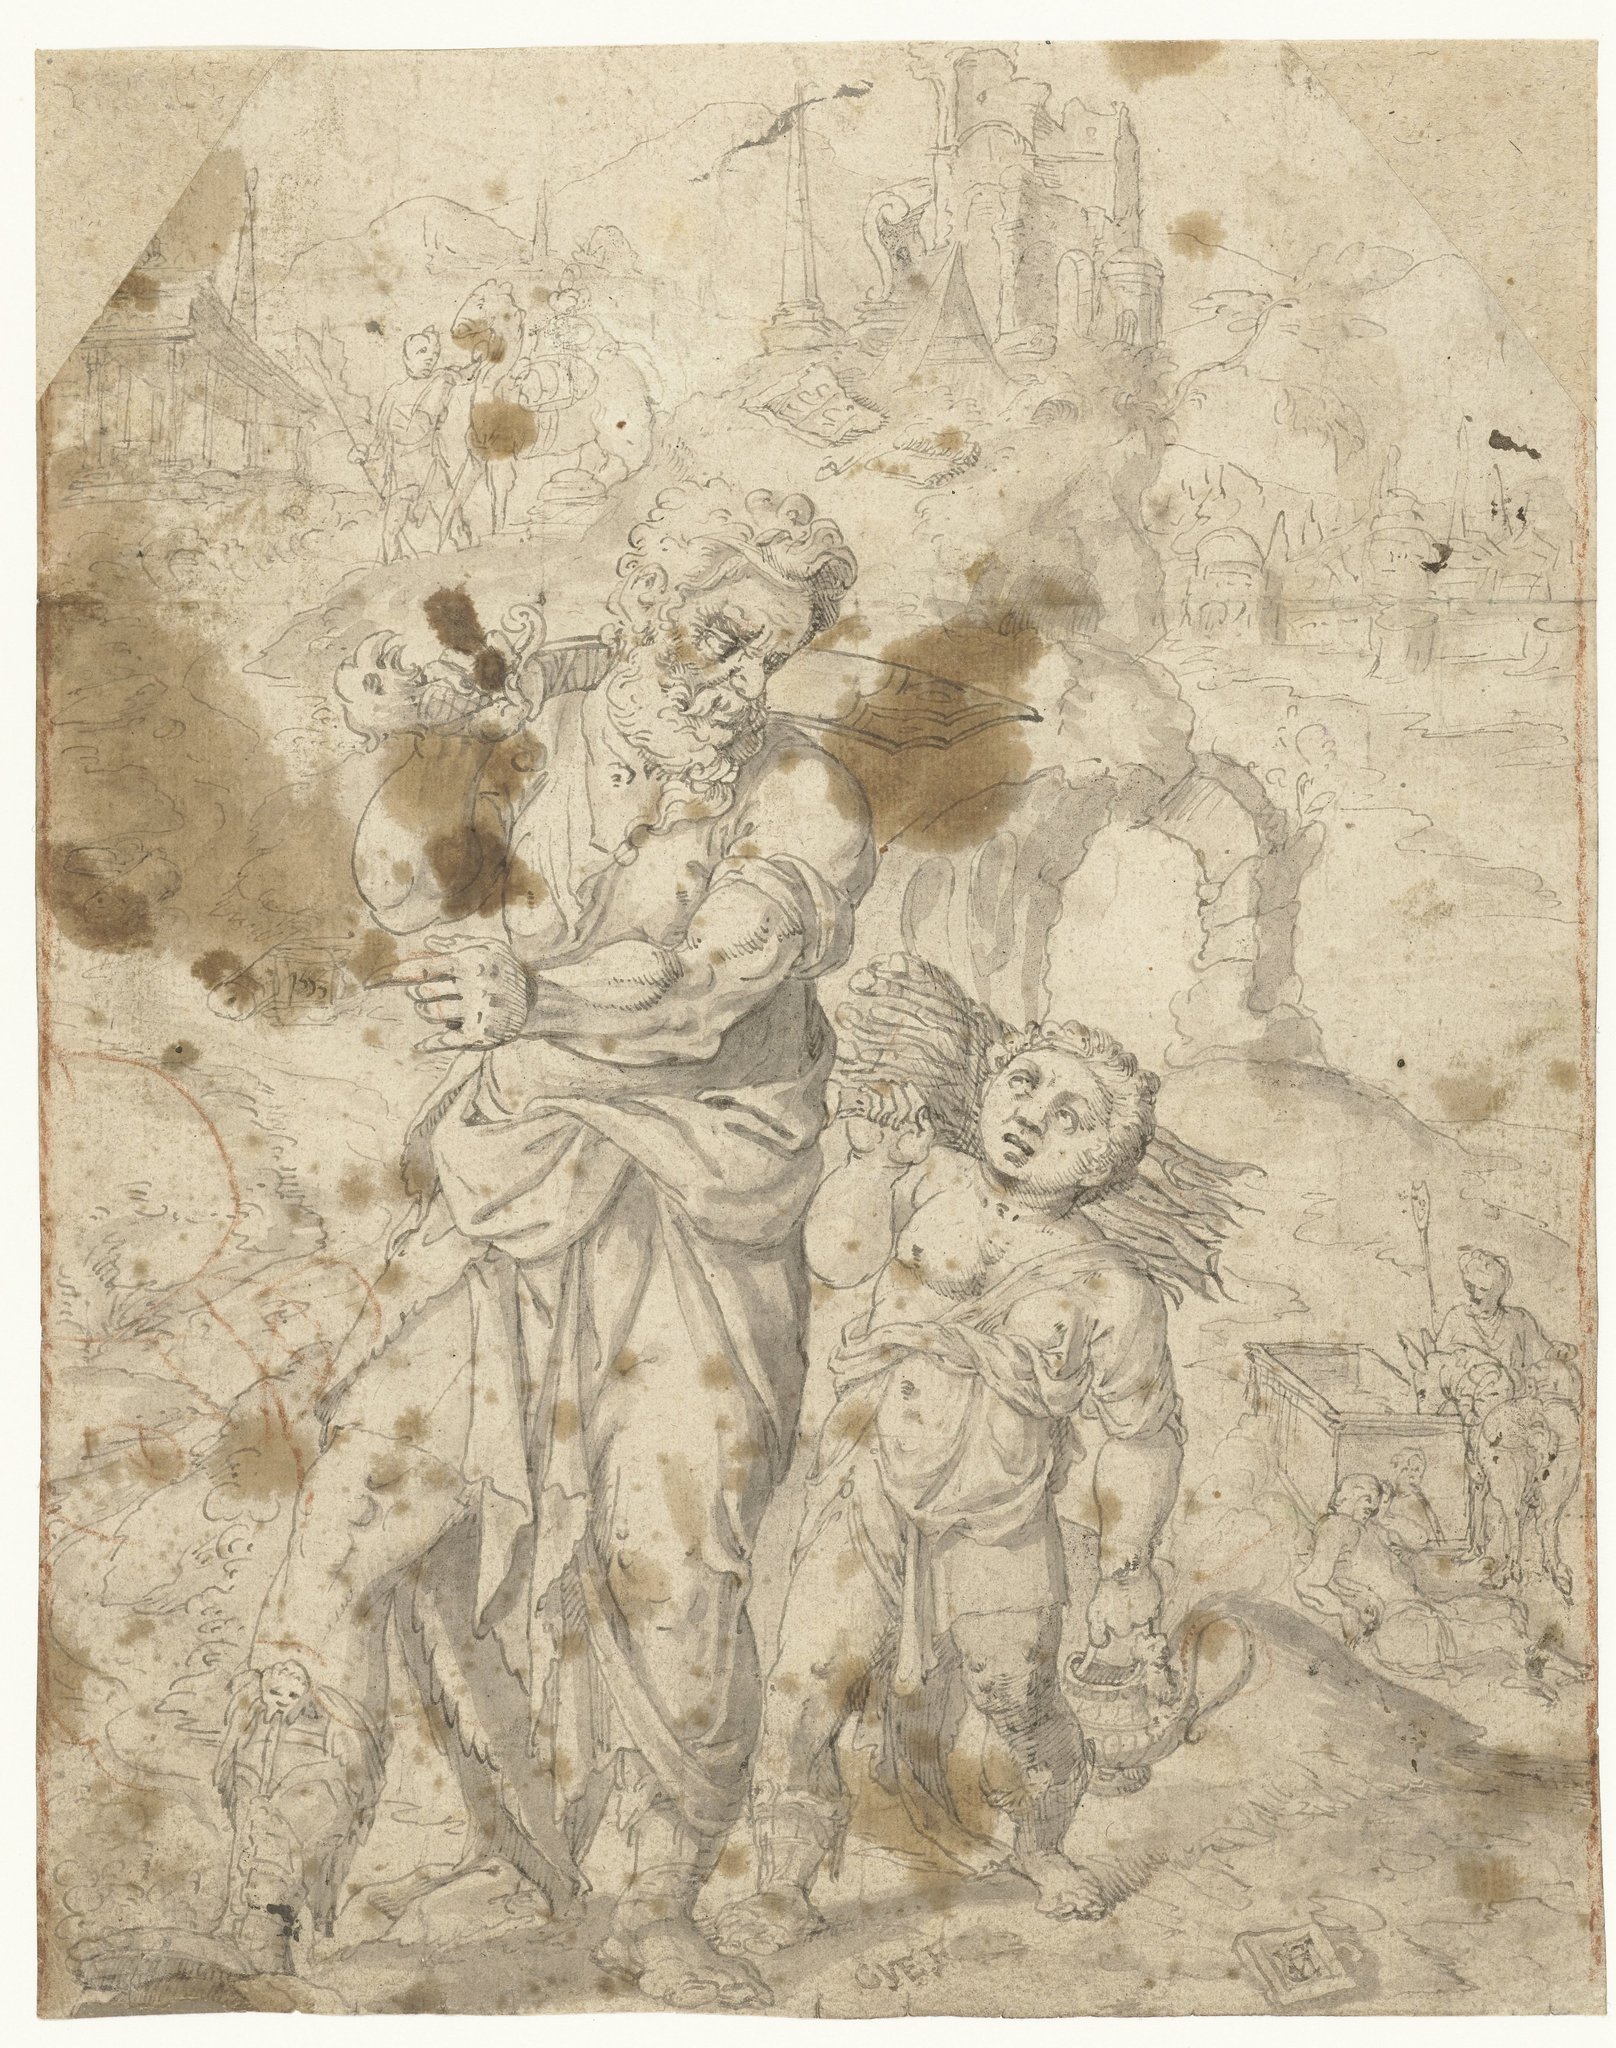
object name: drawing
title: Abraham en Izaäk onderweg naar de offerplaats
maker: monogrammist vch of hvc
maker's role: draughtsman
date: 1553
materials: ink, paper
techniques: brush, pen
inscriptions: date